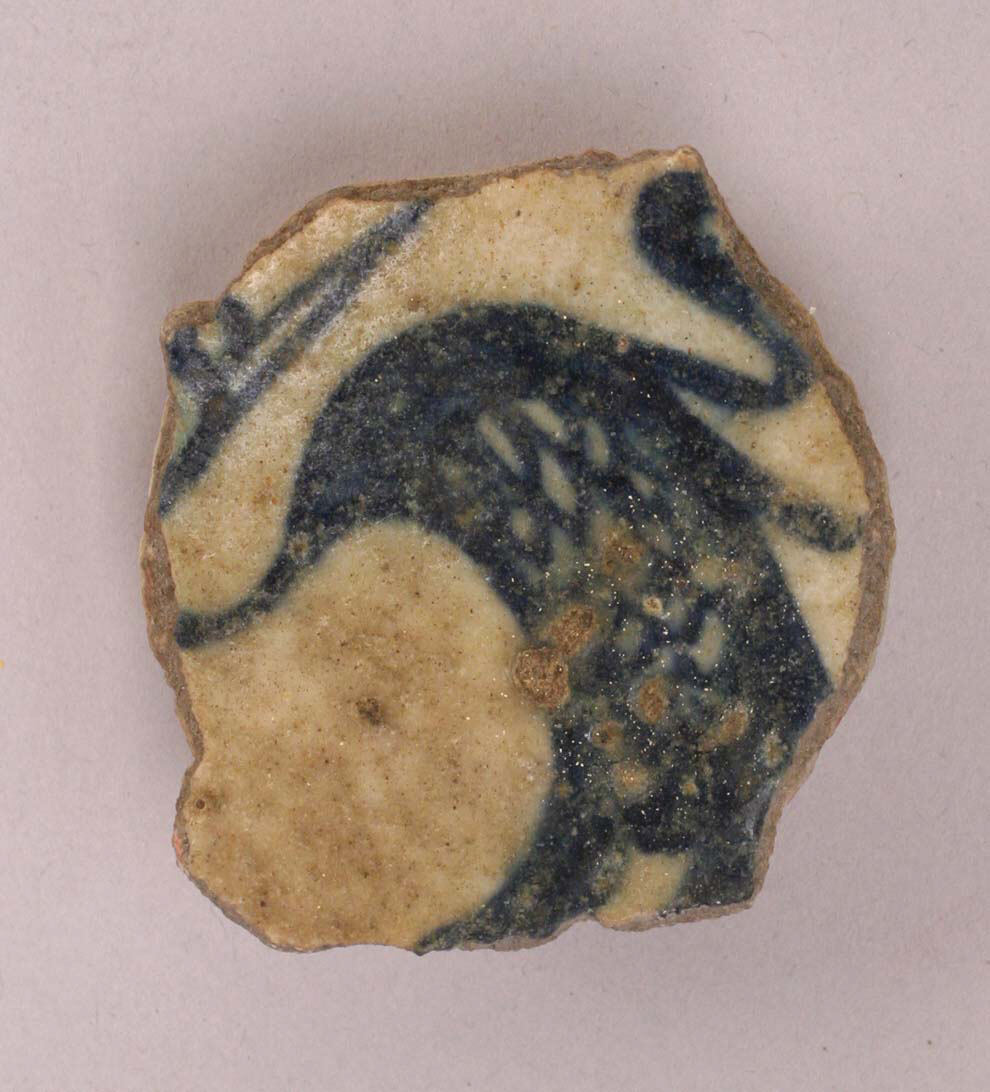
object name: fragment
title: Fragment of a Bowl or Cup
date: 1201-1600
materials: glaze, stonepaste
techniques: painting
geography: egypt